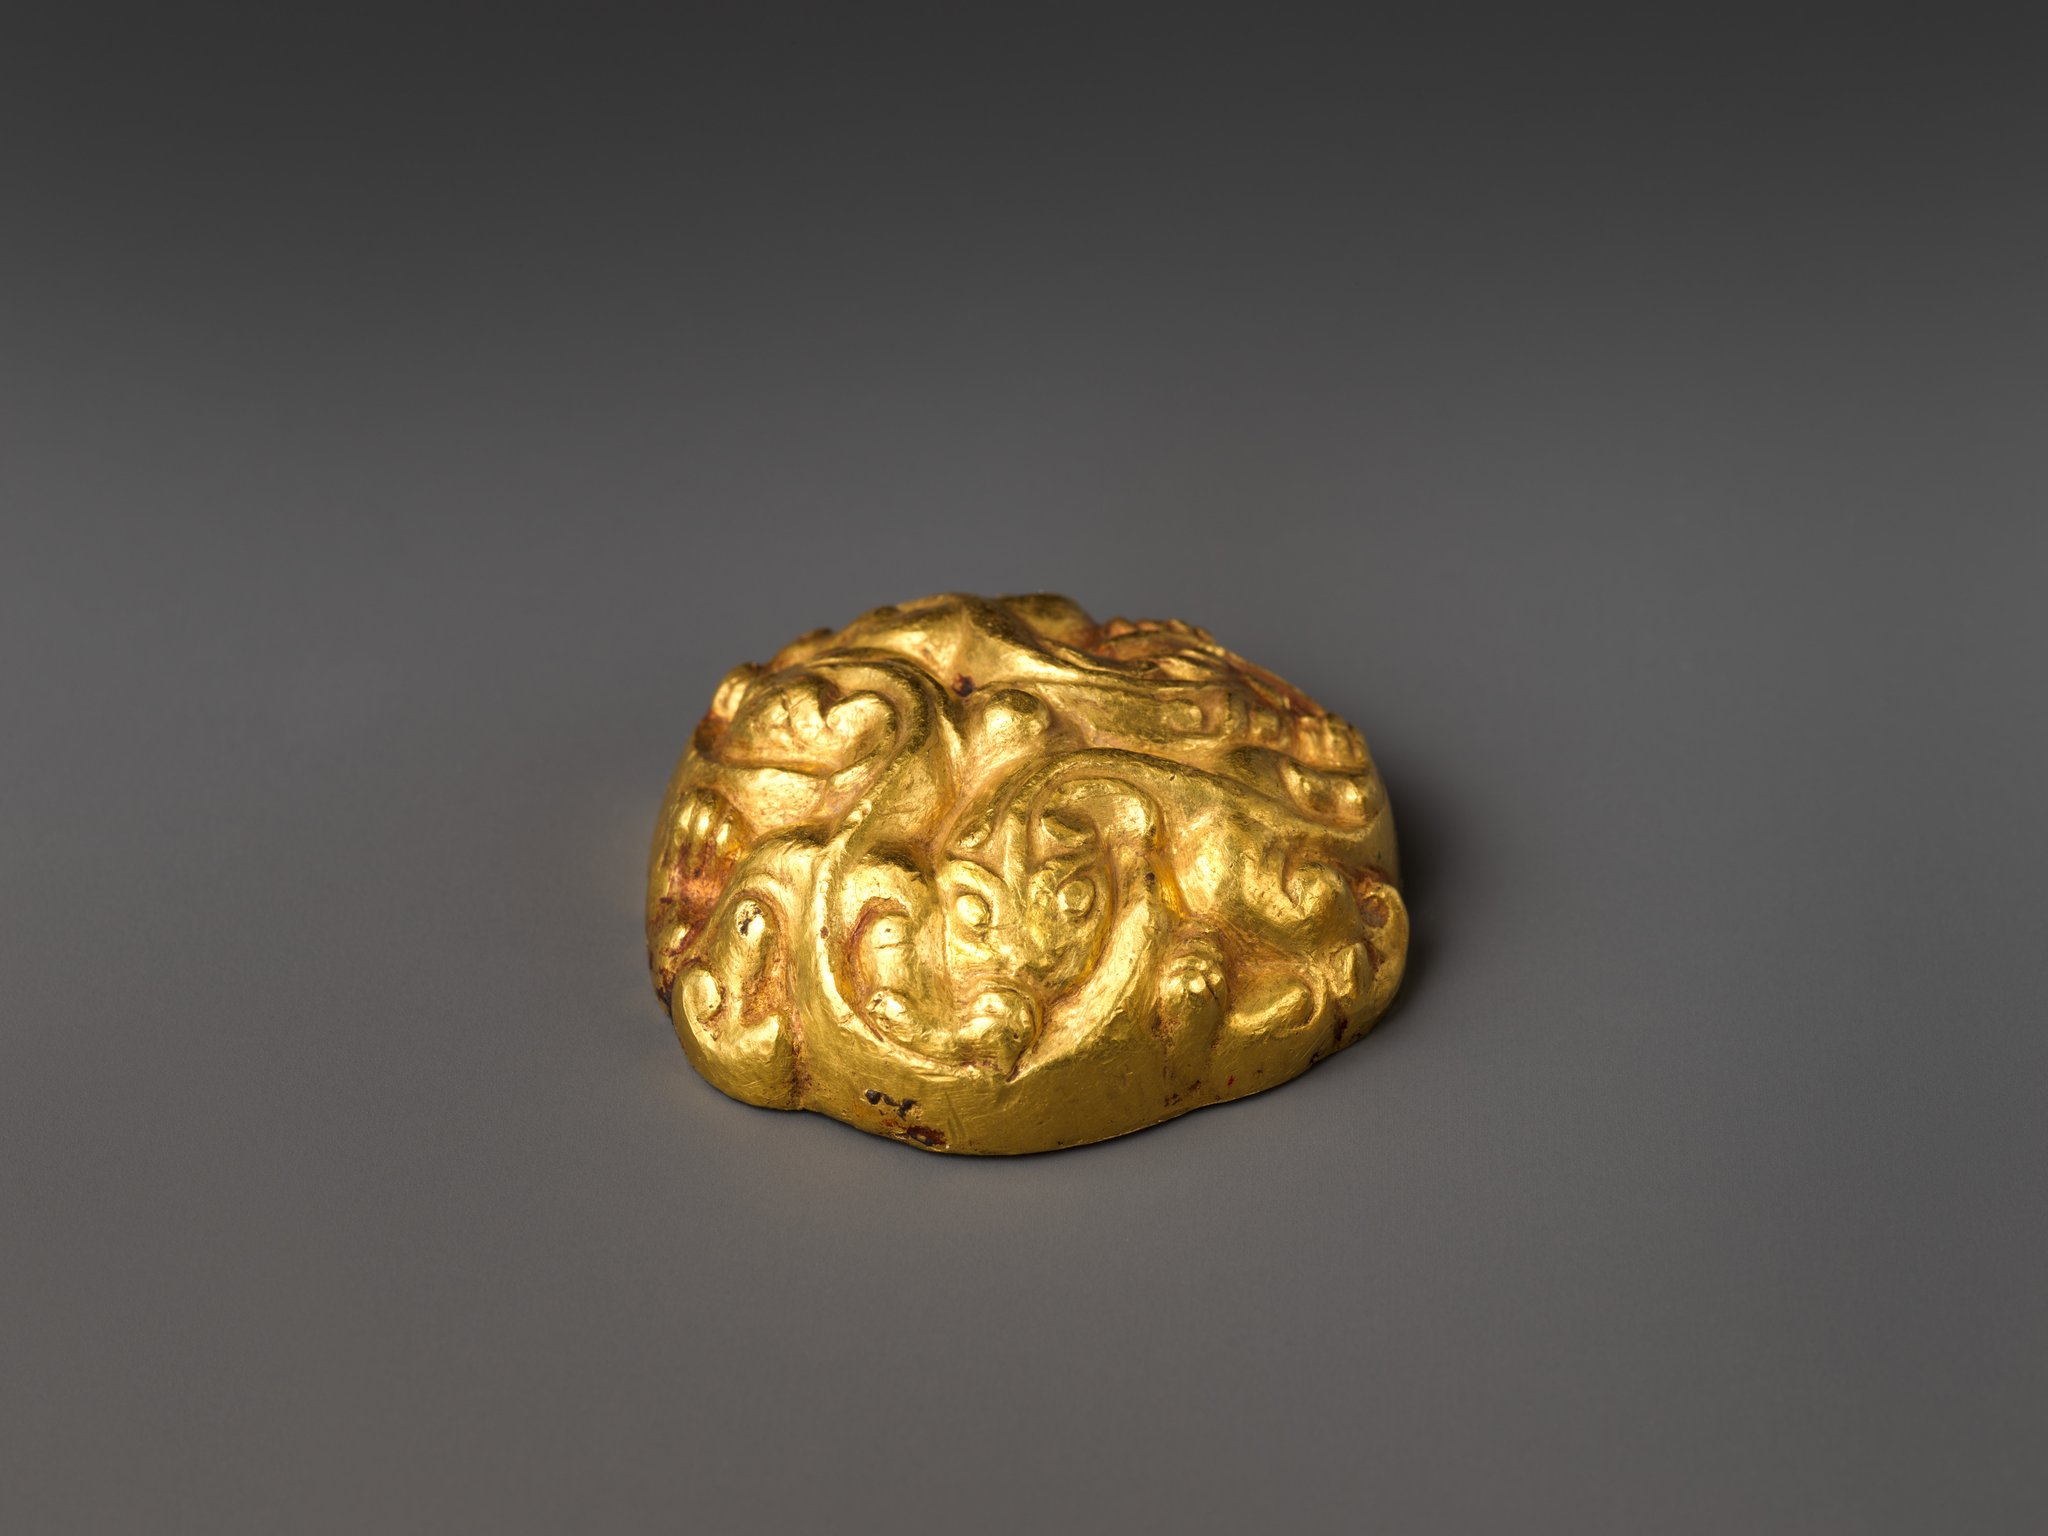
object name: appliqué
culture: chinese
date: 206 BCE-220 CE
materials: gold